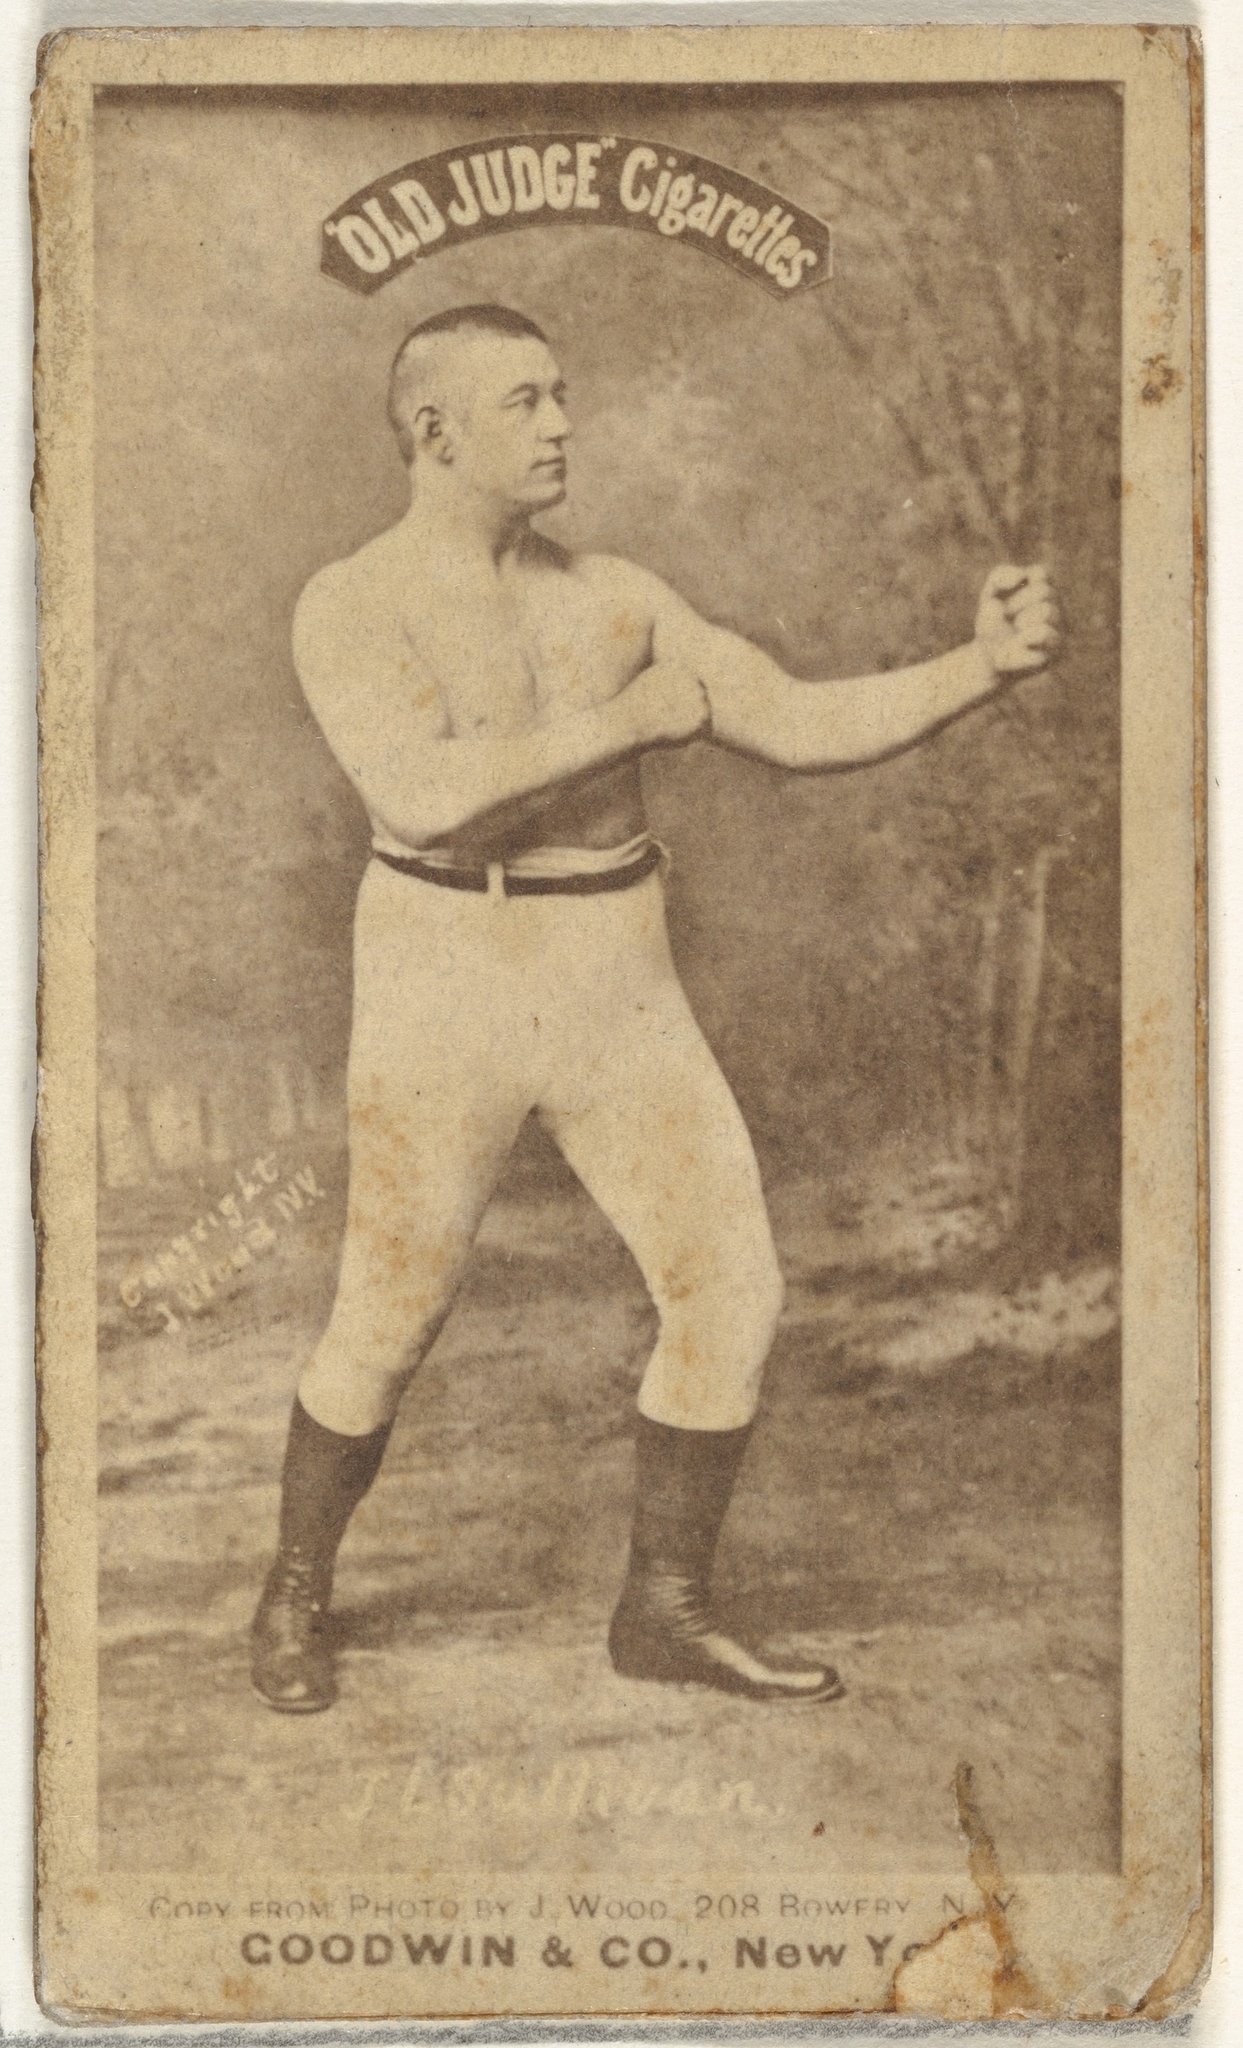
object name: photograph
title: John L. Sullivan, from the Celebrities and Prizefighters series (N174) for Old Judge Cigarettes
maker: goodwin & company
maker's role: publisher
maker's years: 1850-1950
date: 1887-1888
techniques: albumen silver print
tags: men,boxing,athletes